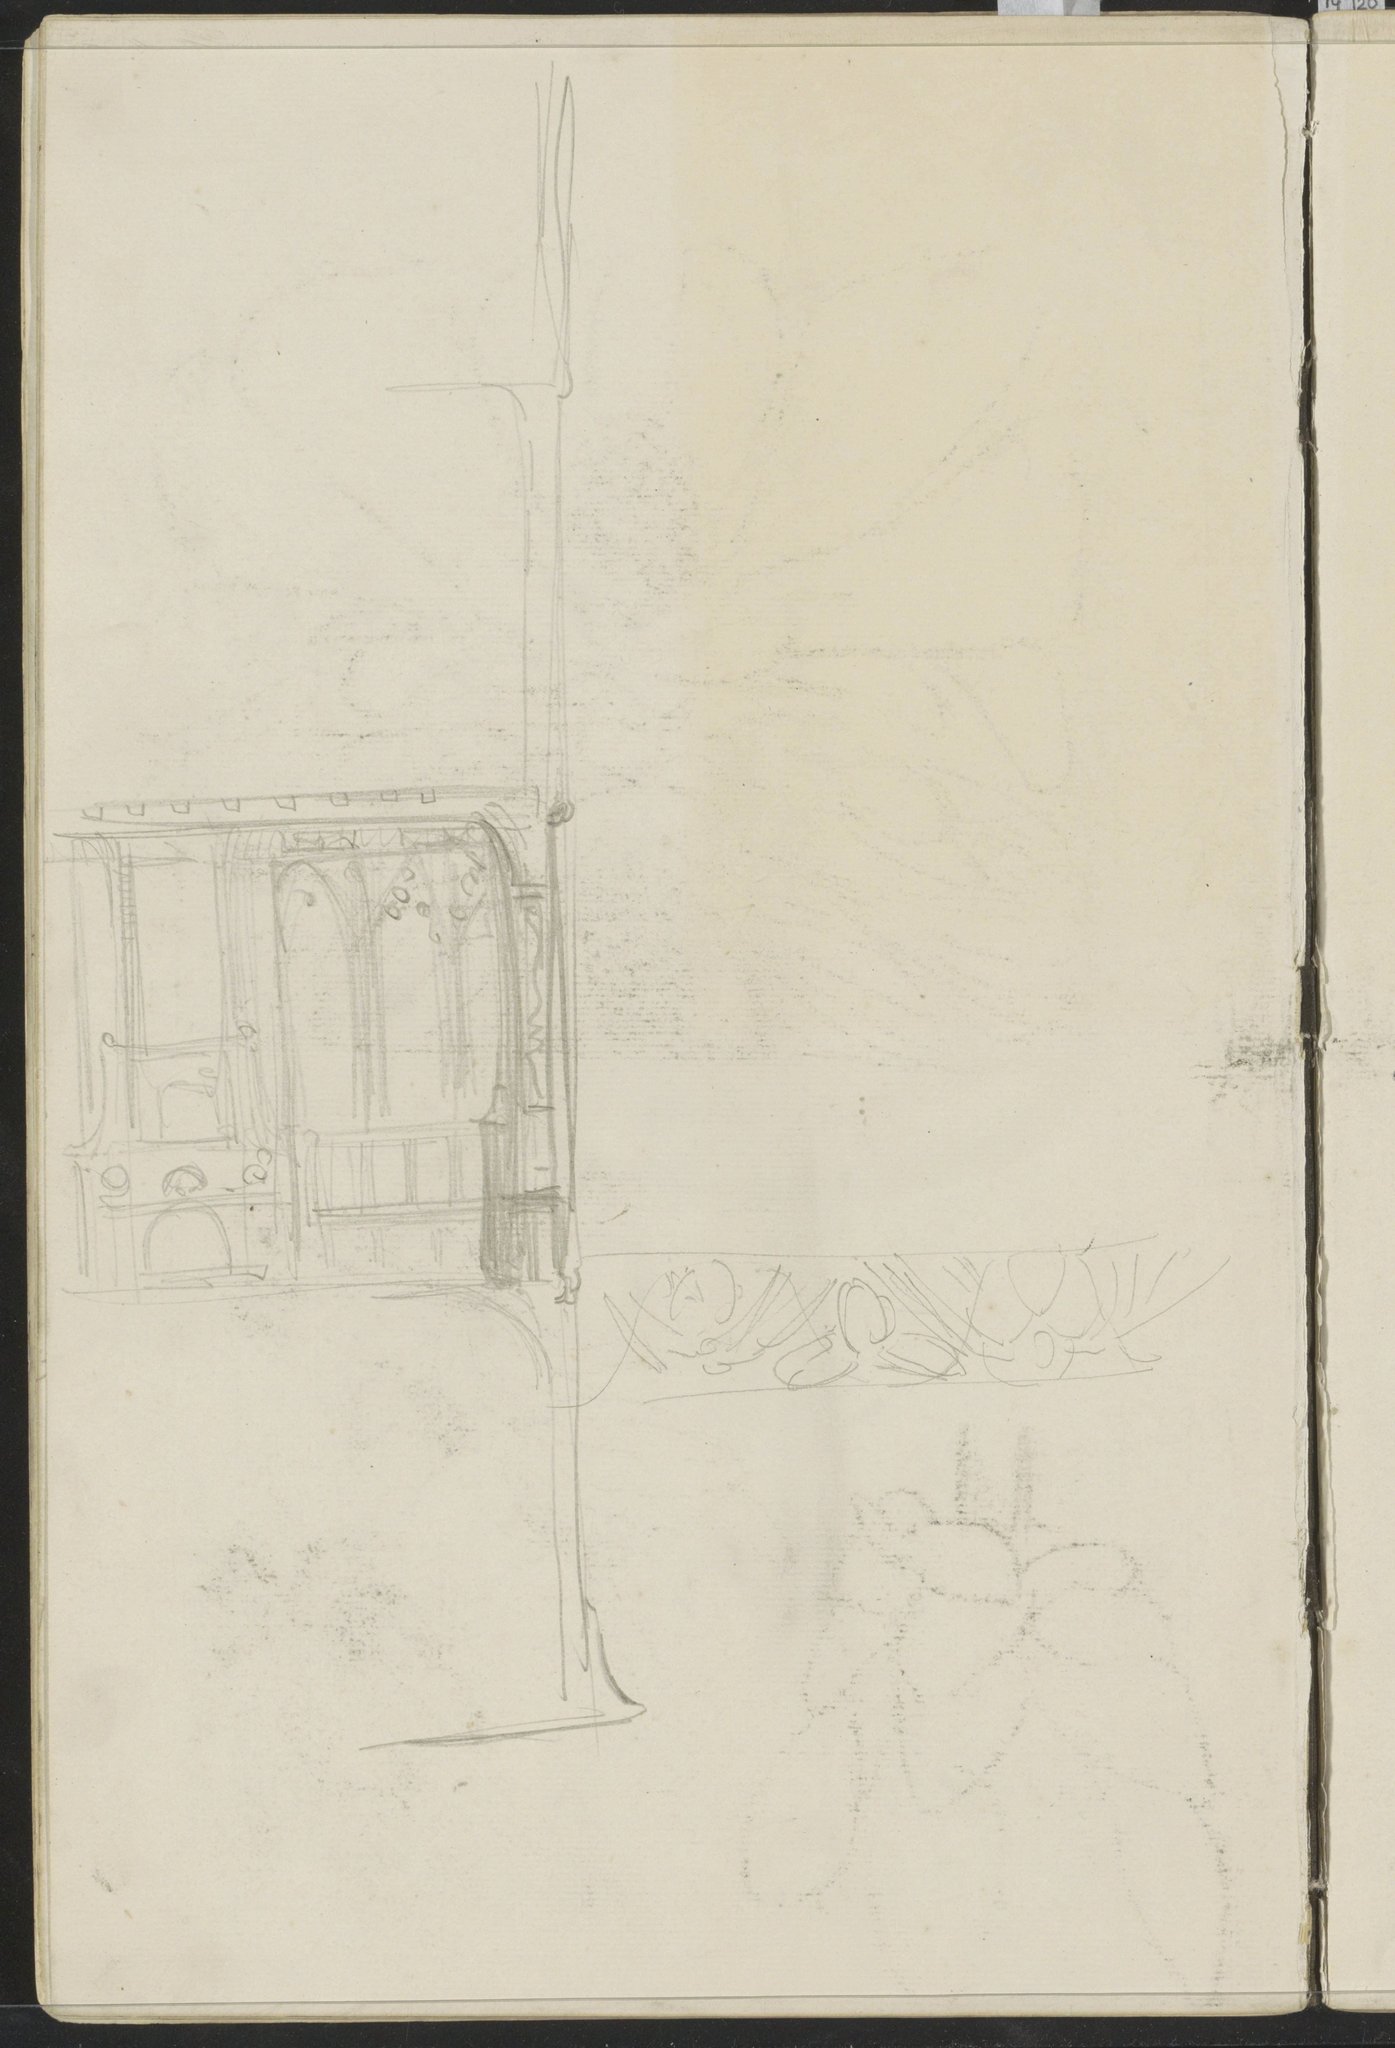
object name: sketchbook leaf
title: Ornamentontwerpen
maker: carel adolph lion cachet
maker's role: draughtsman, print maker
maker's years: 1864-1945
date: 1897-1898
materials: paper, pencil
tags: ornaments ~ art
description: Blad 16 verso uit een schetsboek met 29 bladen.